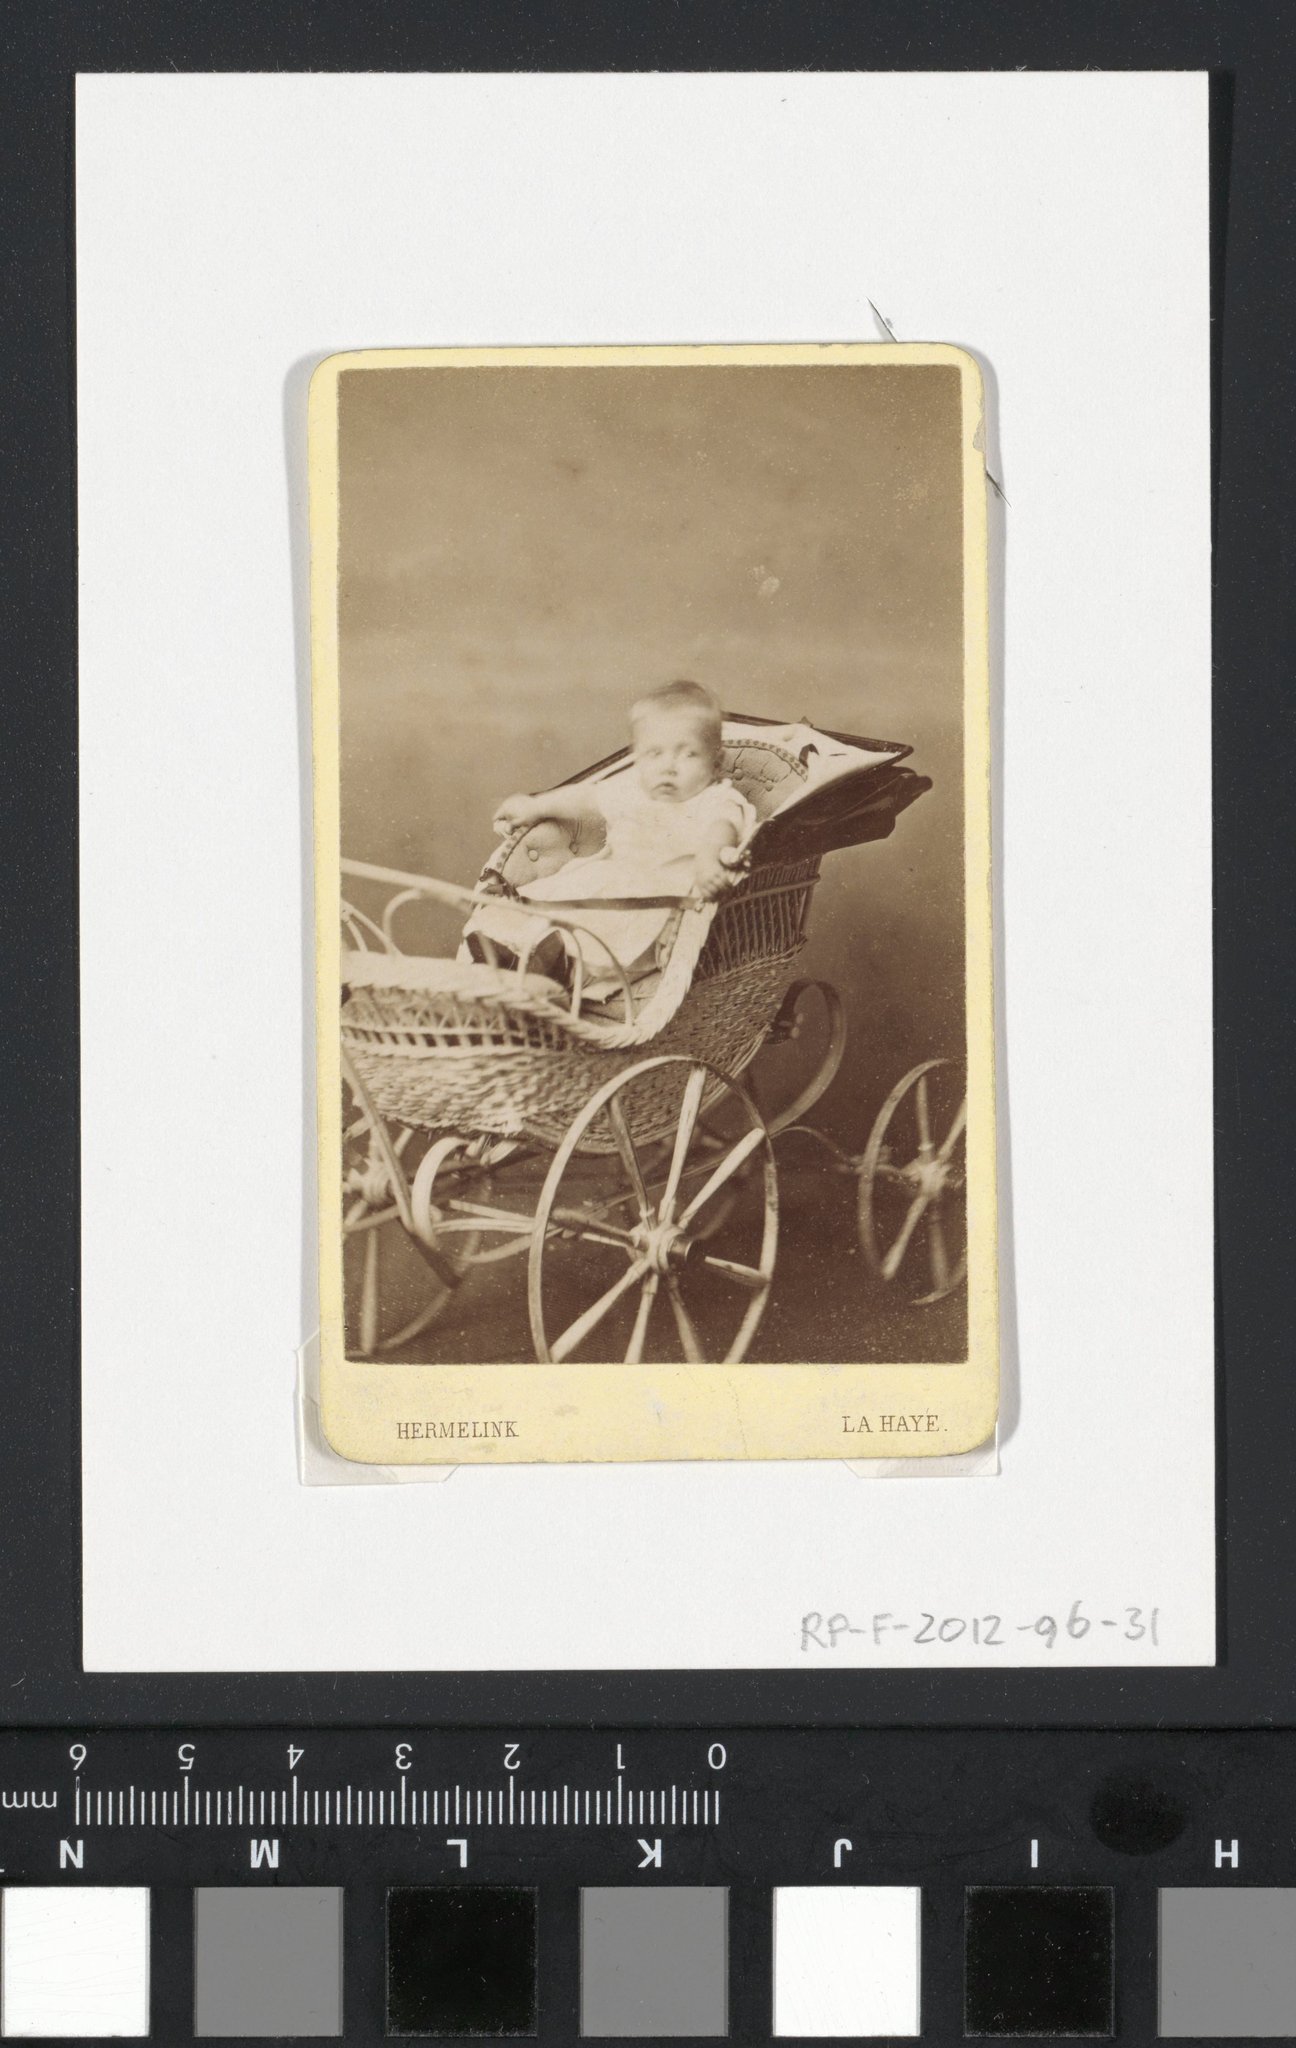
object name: carte de visite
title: Portret van een baby in een kinderwagen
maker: christiaan martinus jan hermelink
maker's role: fotograaf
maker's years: 1840-1933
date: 1867-1885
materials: cardboard, paper, photographic support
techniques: albumen print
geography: the hague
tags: studio requisites ~ photographer, historical persons, infant, baby ~ the ages of man, the hague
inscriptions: address: ‘62 Dennenweg La Haye’